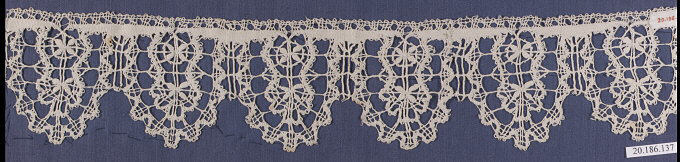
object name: strip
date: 1601-1700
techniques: lace